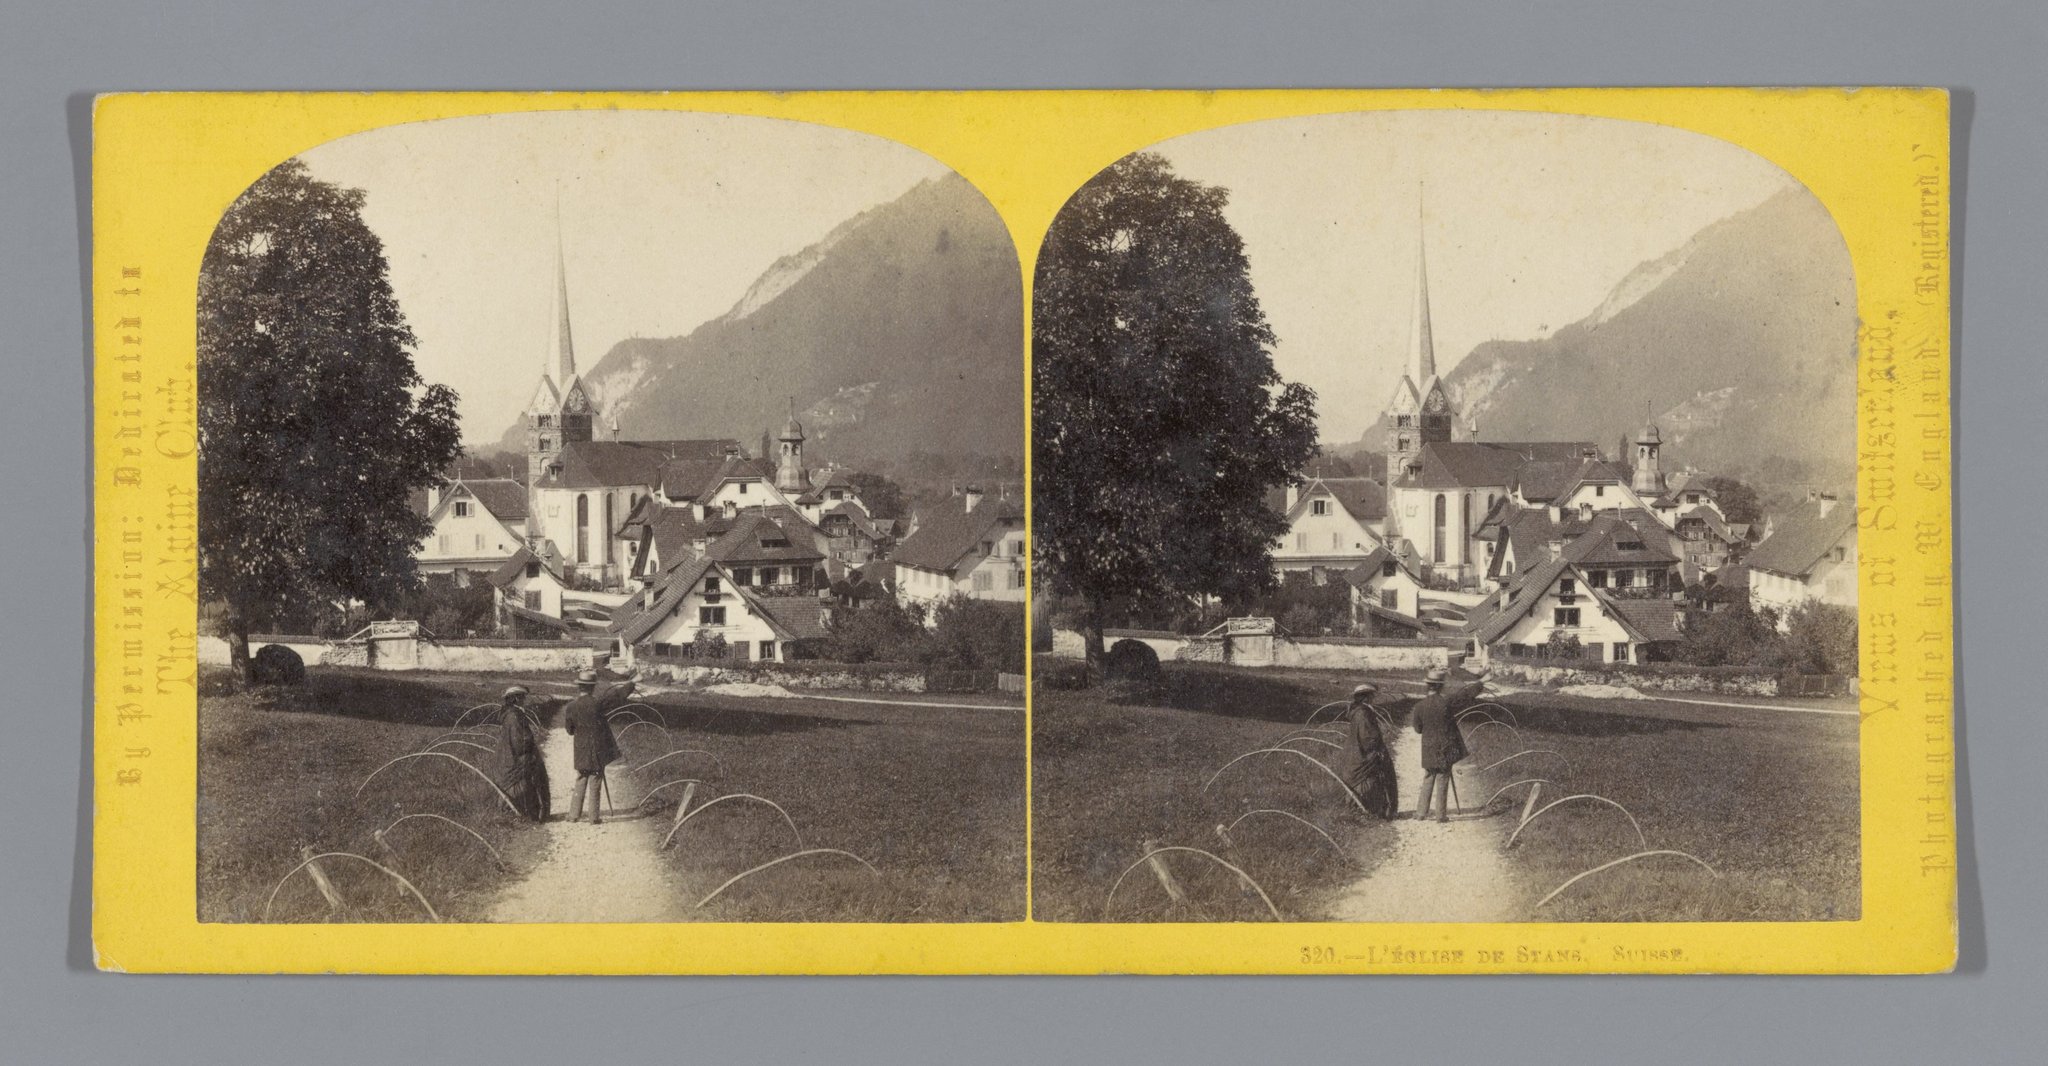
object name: stereograph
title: L'église de Stans. Suisse.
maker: william england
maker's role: fotograaf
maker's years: 1816-1896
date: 1850-1880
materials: cardboard, photographic support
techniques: albumen print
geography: stans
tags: church (exterior)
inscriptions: number: ‘320.’, inscription: ‘Views of Switzerland, photographed by W. England. (Registered) Under the Special Patronage of the Alpine Club.’